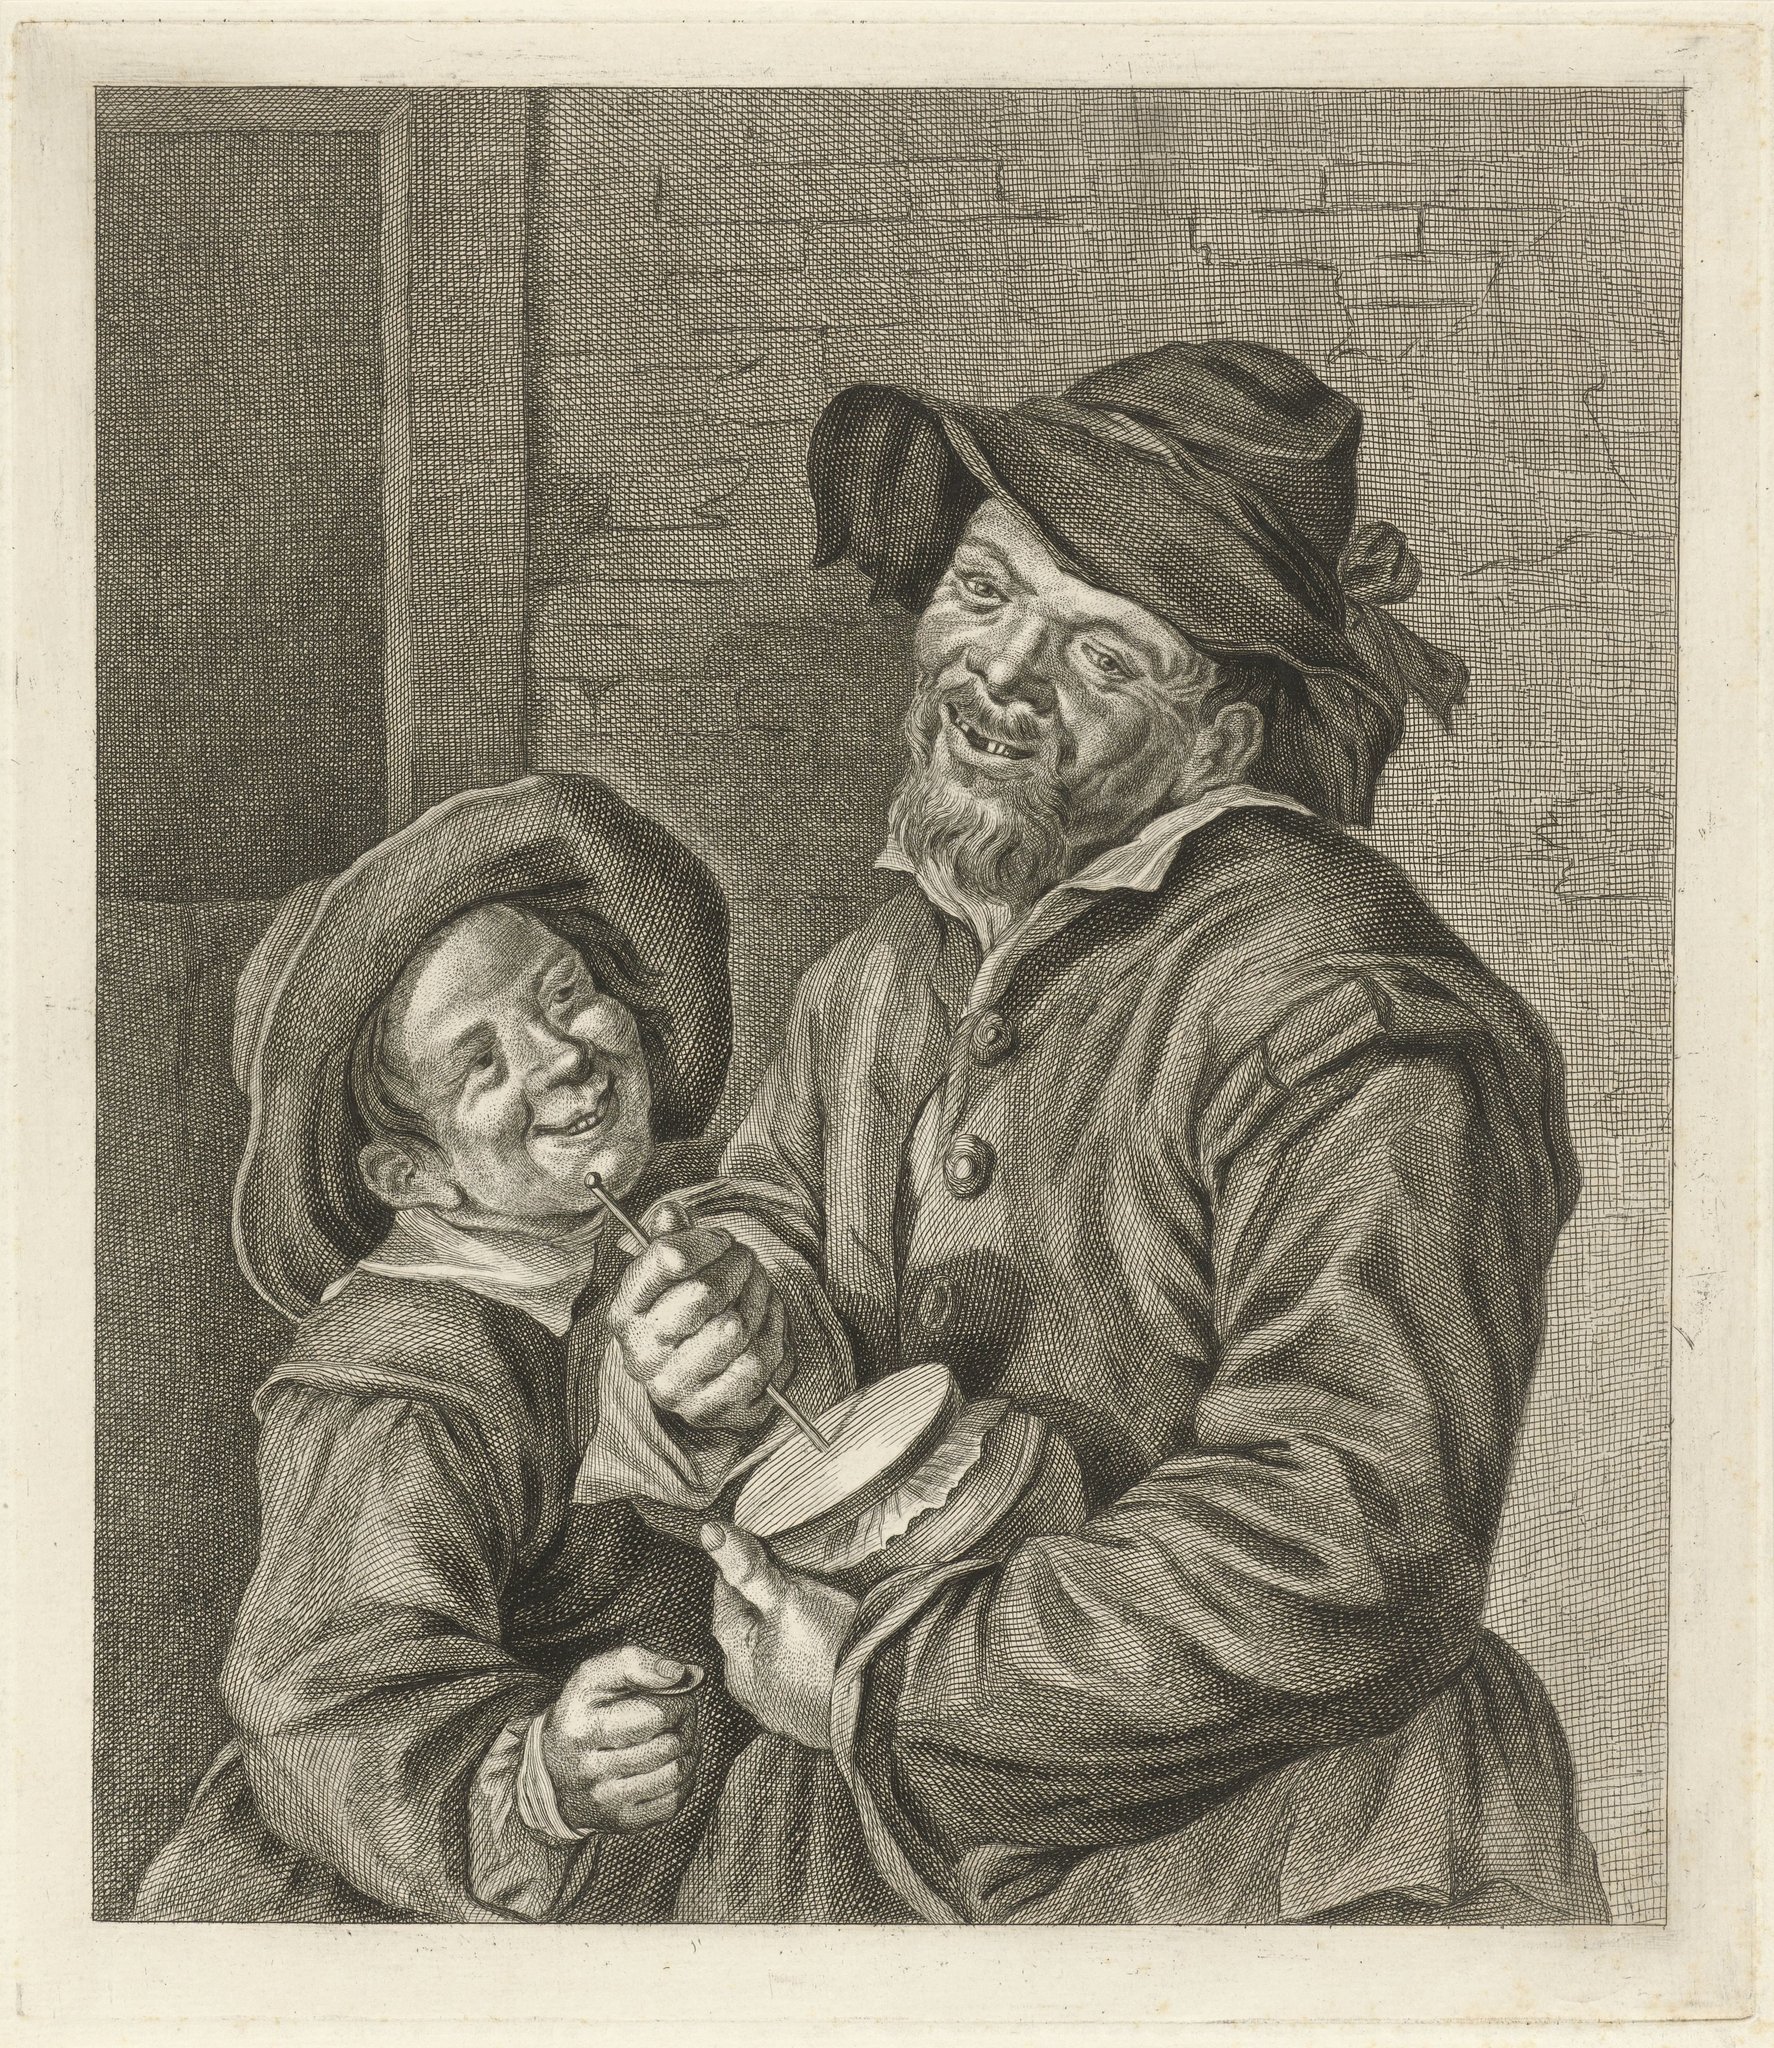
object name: print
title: De rommelpotspeler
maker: pieter de mare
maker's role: print maker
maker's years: 1758-1796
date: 1768-1796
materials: paper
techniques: engraving, etching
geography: leiden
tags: one person playing wind instrument, improvised musical instruments: rumbling pot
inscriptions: collector's mark: Lugt 240